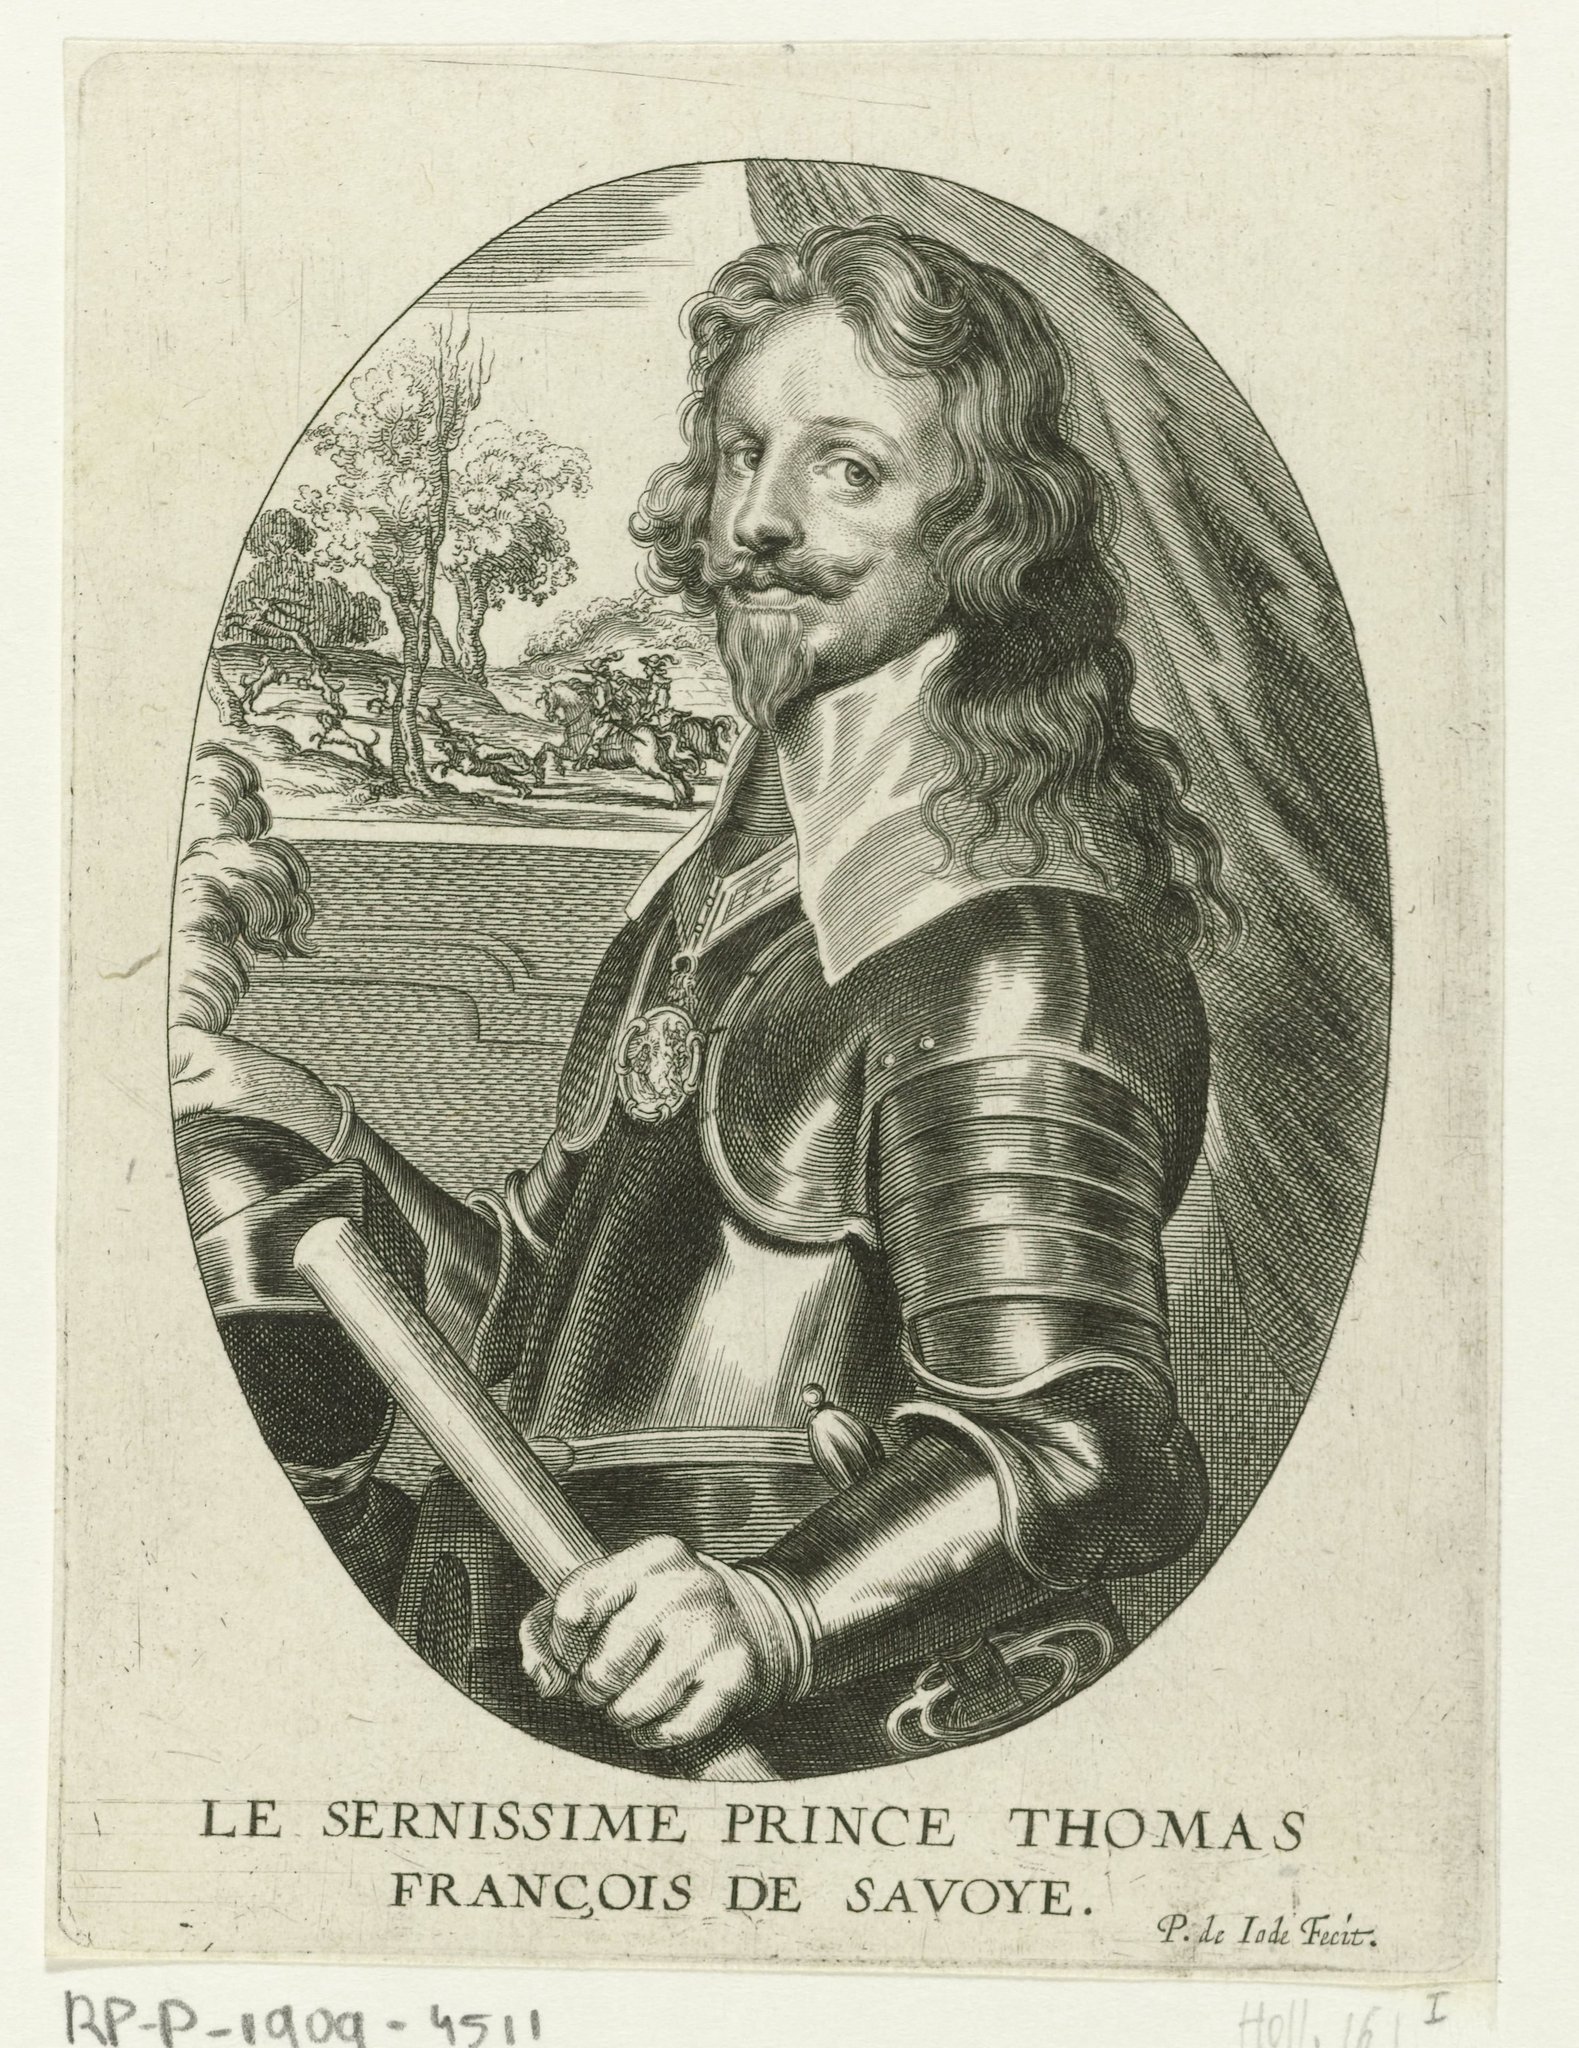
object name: print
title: Theatrum pontificum, imperatorum, regum, ducum, principum, etc.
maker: pieter de jode (ii)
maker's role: draughtsman, print maker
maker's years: 1606-1674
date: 1628-1670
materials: paper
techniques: engraving, etching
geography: antwerp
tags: stag-hunting, armour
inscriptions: collector's mark: Lugt 2228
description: Portret van Tommaso Francesco van Savoye, ten halven lijve. Hij draagt een harnas en in zijn linkerhand houdt hij een commandostaf. Zijn rechterhand rust op zijn helm. Op de achtergrond een hertenjachtscène. Het portret is gevat in een ovaal. In de marge een tweeregelig onderschrift in het Latijn.